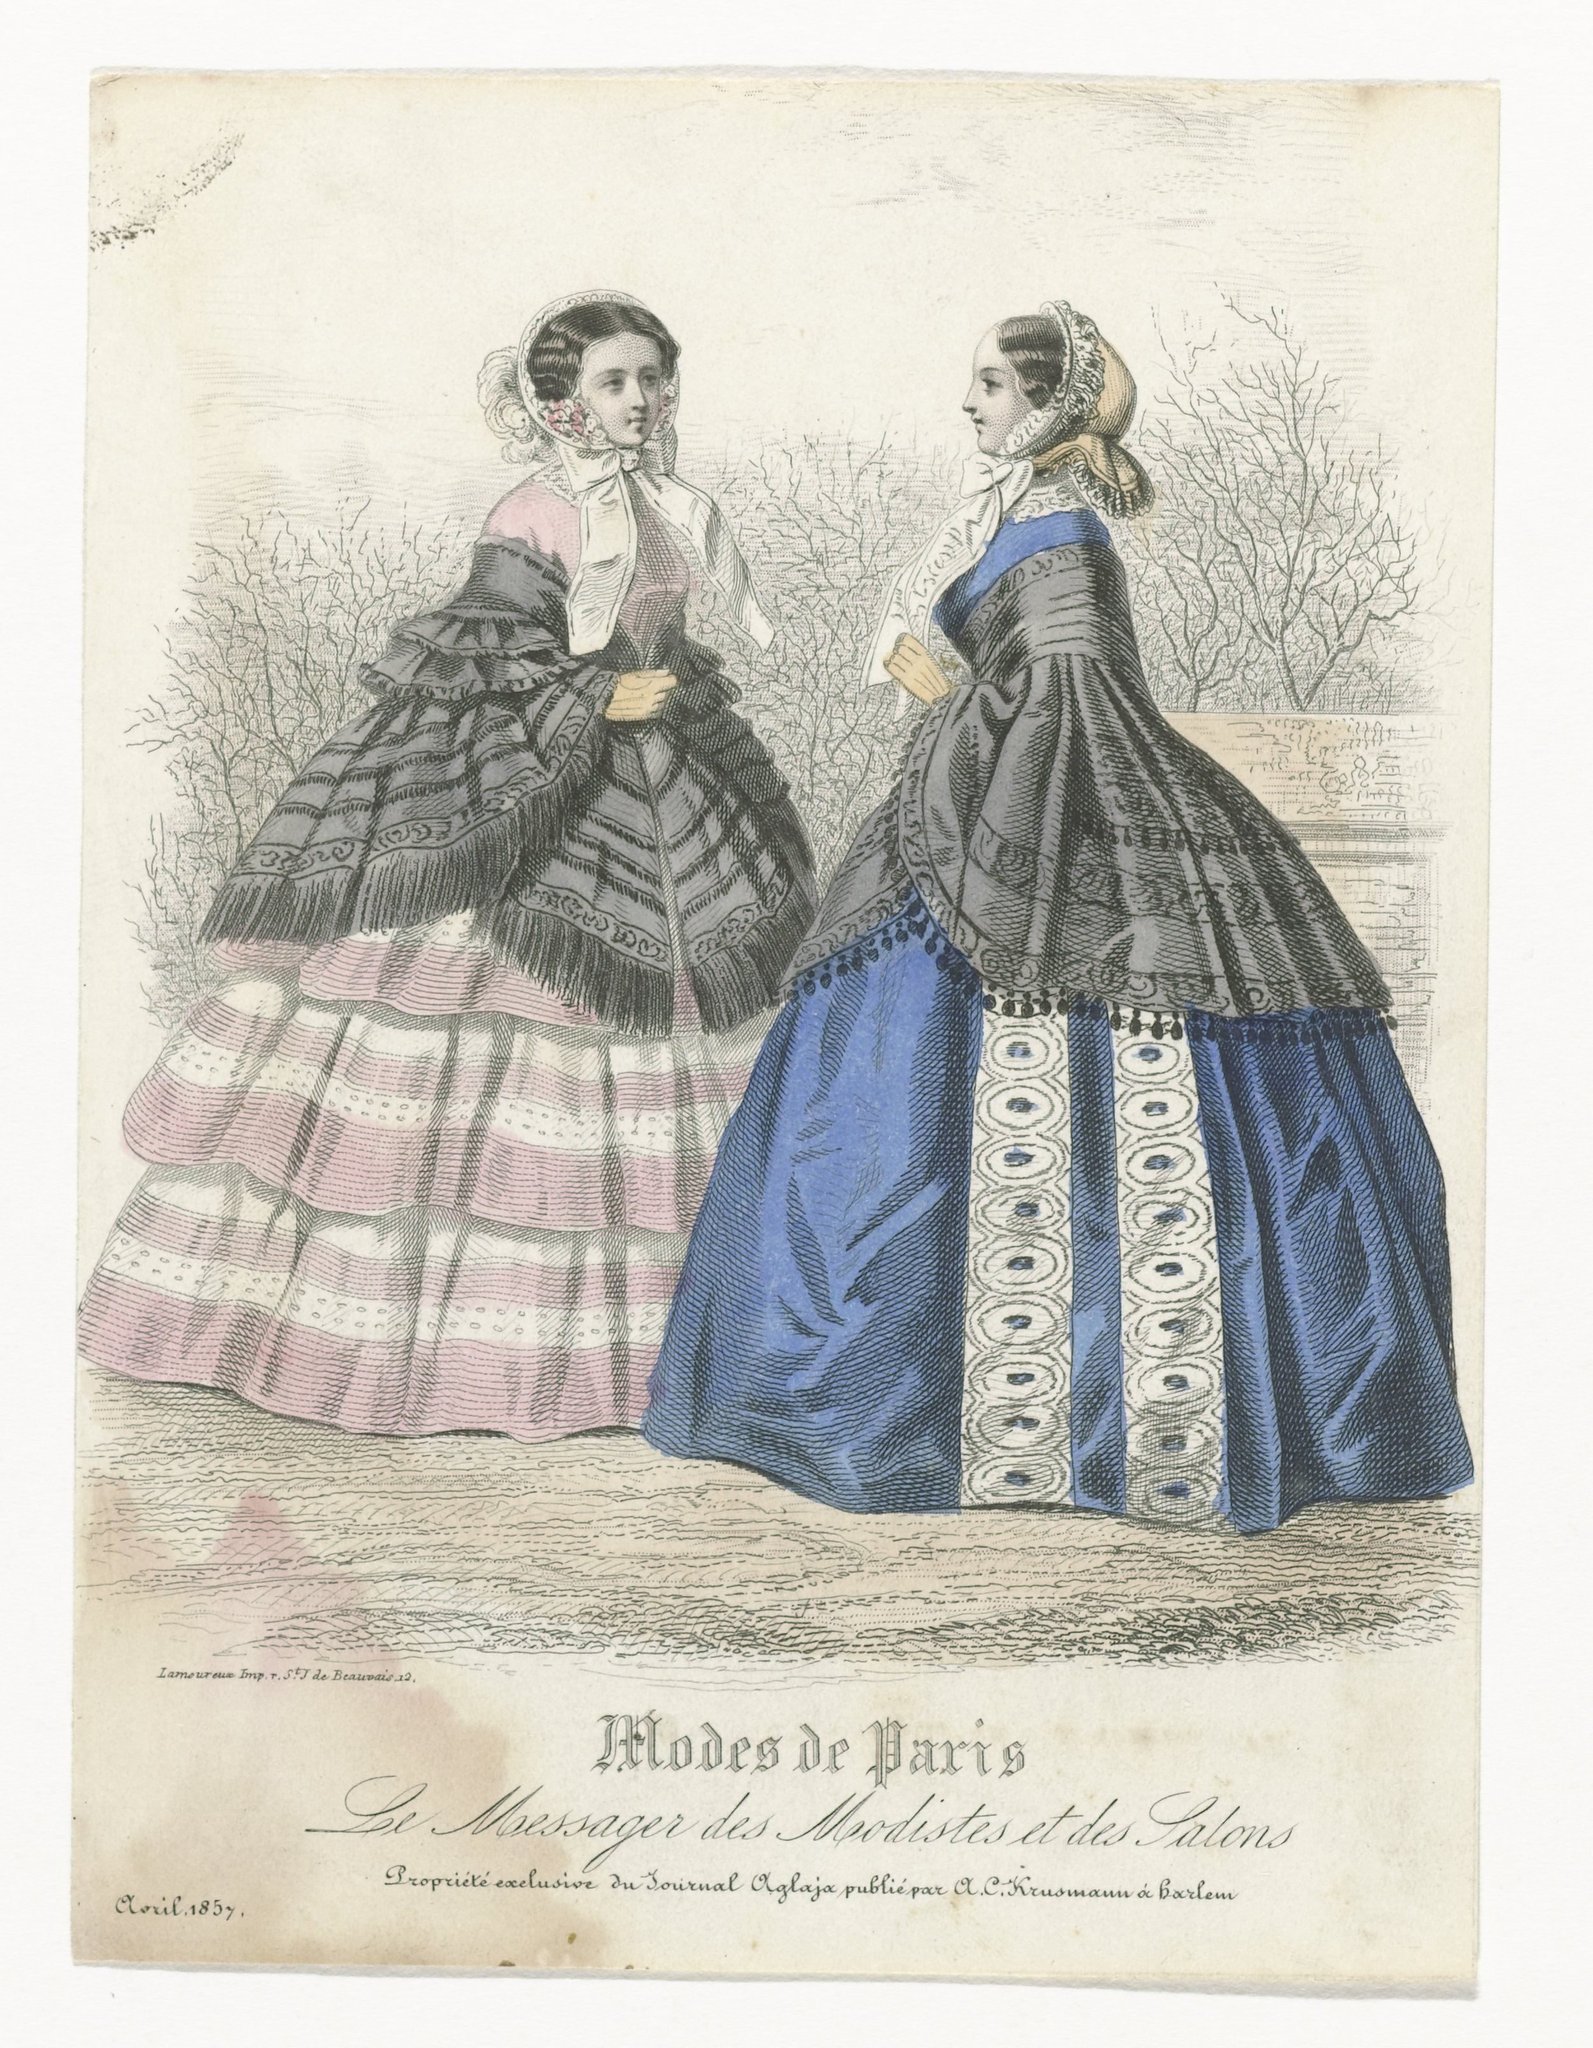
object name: fashion print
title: Le Messager des Modistes et des Salons, Modes de Paris, Journal Aglaja, avril 1857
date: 1857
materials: paper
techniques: engraving, hand coloring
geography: haarlem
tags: clothing for the upper part of the body (mantelet) (+ women's clothes), fashion plates, head-gear: hat (+ women's clothes), gloves, mittens, etc. (+ women's clothes)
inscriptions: caption: ‘Propriété exclusive du Journal Aglaja publié par A. C. Krusmann à Harlem’, title: ‘Modes de Paris / Le Messager des Modistes et des Salons’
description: Twee vrouwen in een park: Links: zwarte schoudermantel afgezet met franjes. Roze japon met wijde strokenrok met wit/roze strepenmotief. Rechts: zwarte schoudermantel met strepenmotief en afgezet met bolletjes. Blauwe japon met wijde rok versierd met twee verticale witte banen met cirkelmotief. De prent werd opgenomen in Aglaja (1848-1864), maandboekje voor dames handwerken, uitgegeven door A. C. Kruseman.